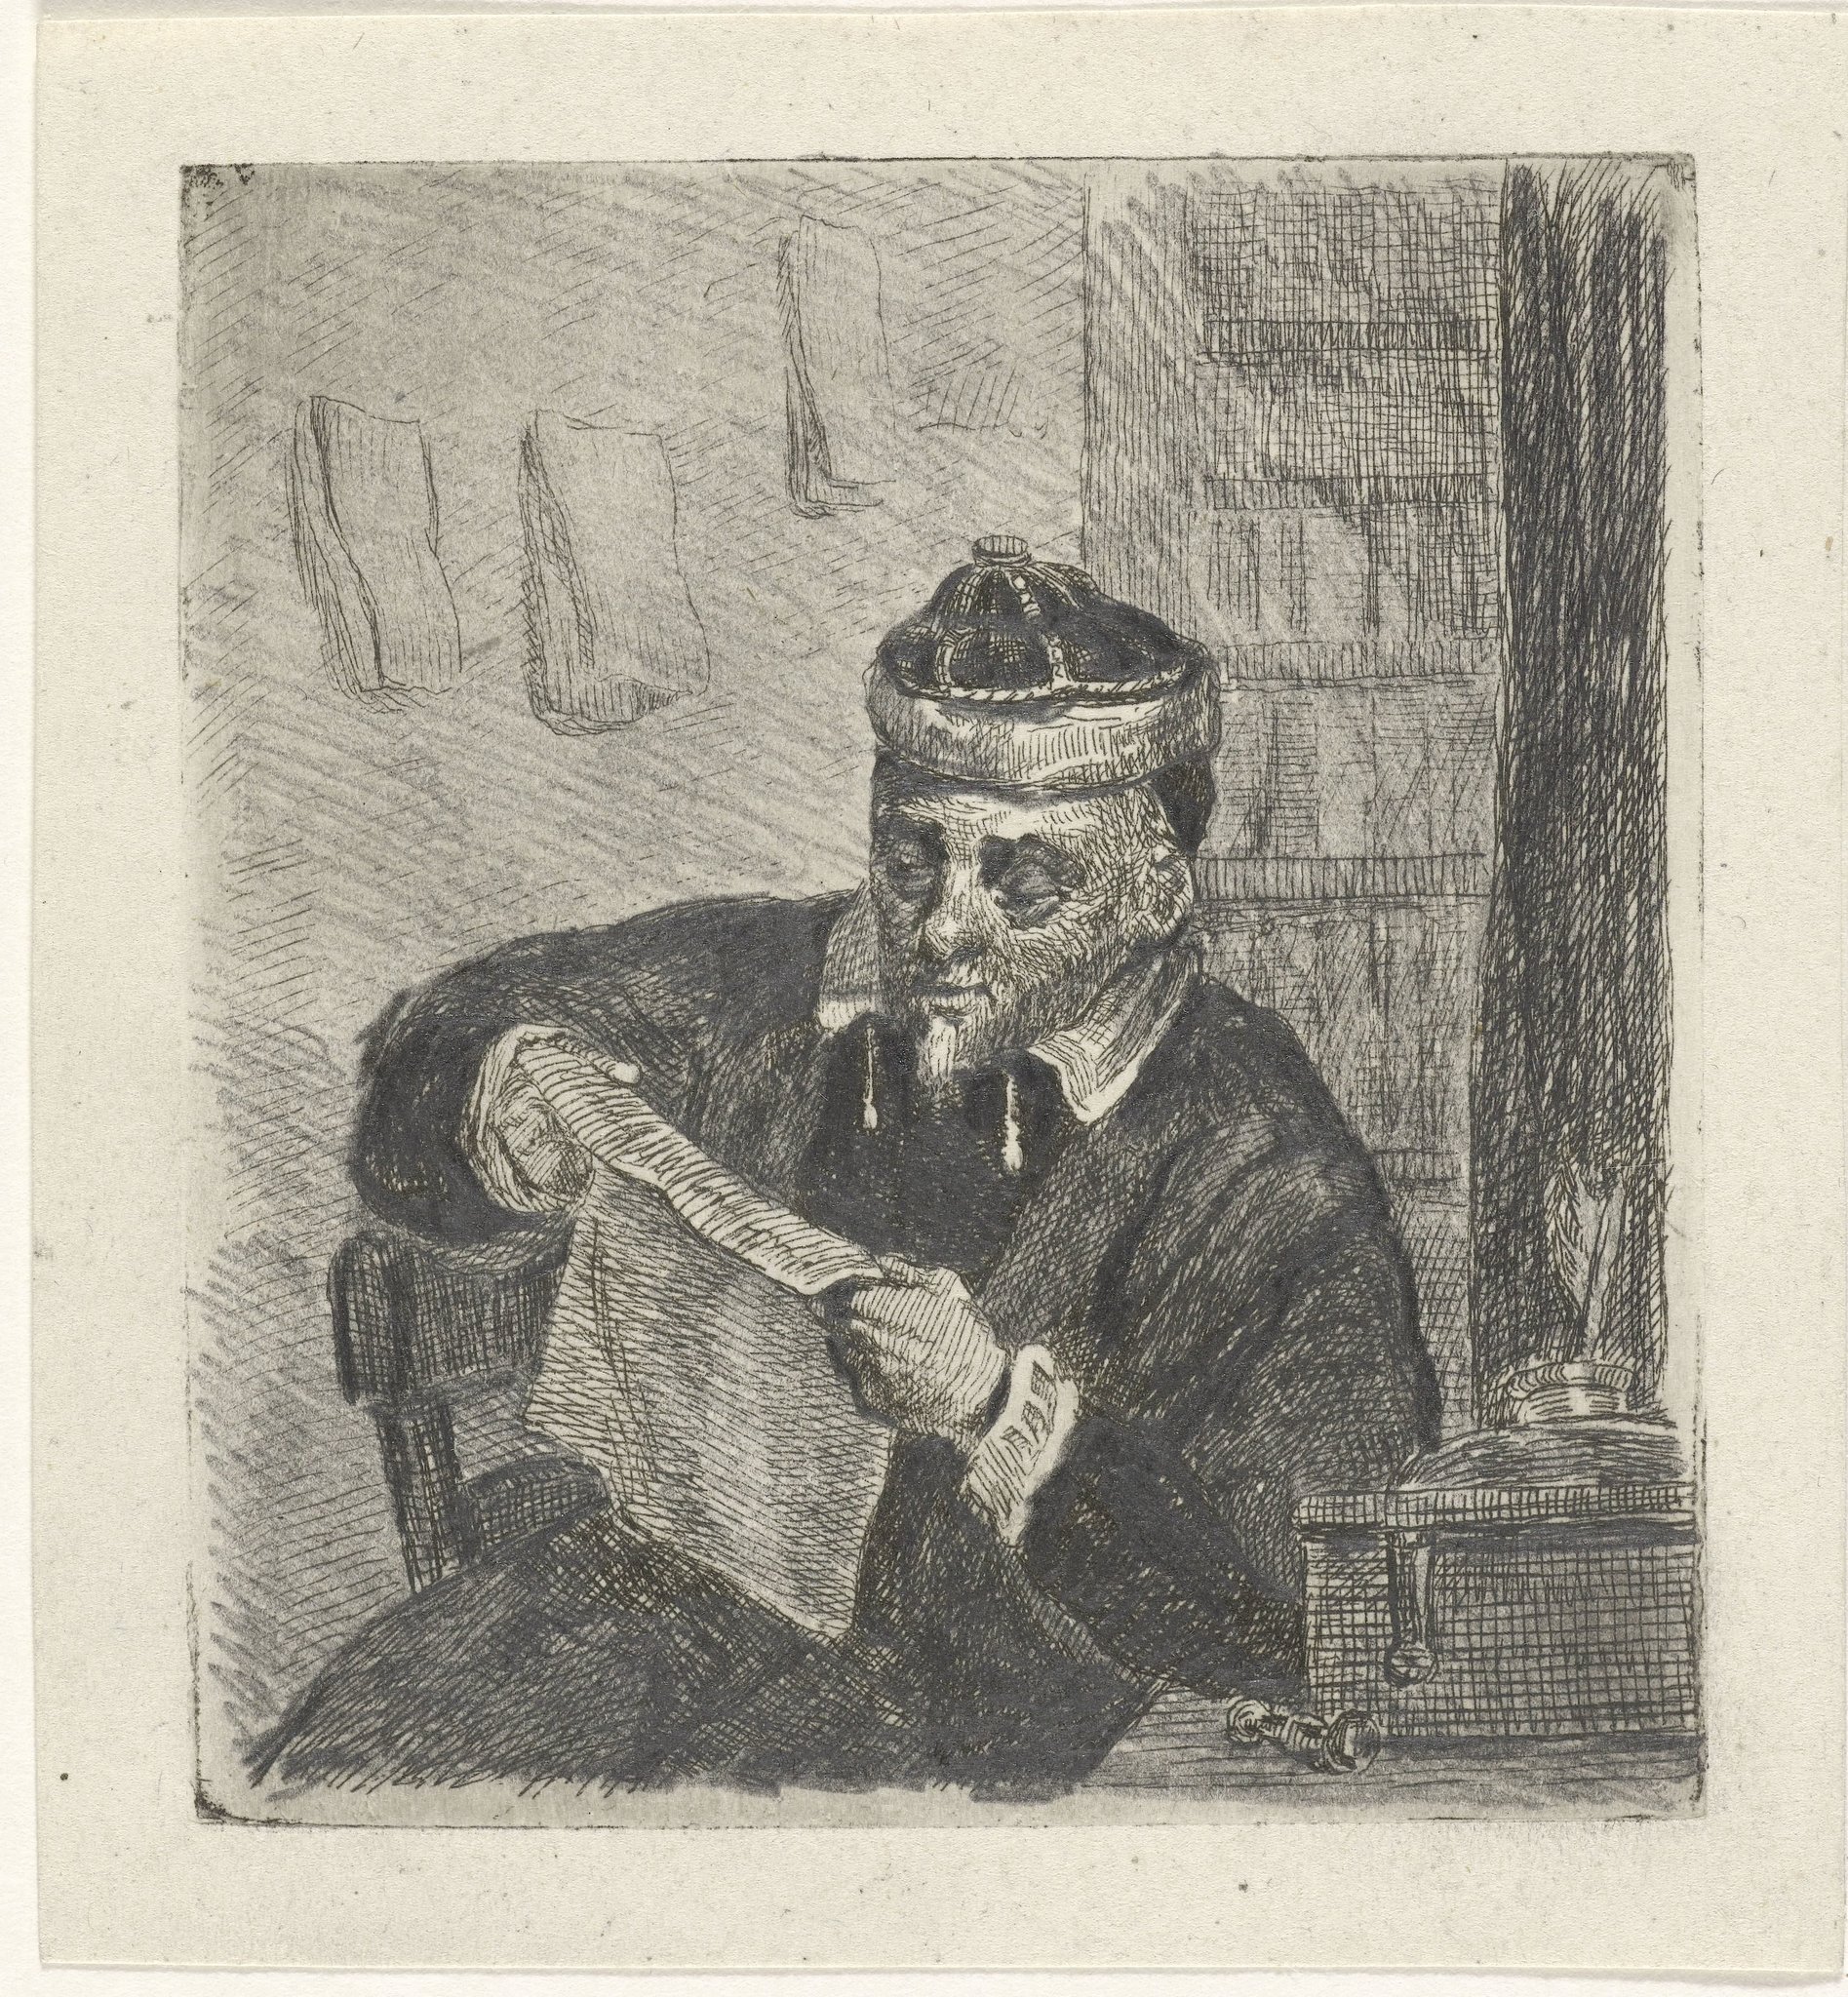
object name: print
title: Lezende man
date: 1814-1879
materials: paper, pencil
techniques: etching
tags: reading, head-gear, adult man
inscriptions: collector's mark: Lugt 2228, inscription: ‘naar P C Wonder’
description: In een studeerkamer zit een man met een muts op zijn hoofd bij een lessenaar een vel papier te lezen. Op de lessenaar staat een pot met daarin een schrijfveer. Achter de man is een deel van een boekenkast zichtbaar en aan de muur hangen enkele vellen papier.